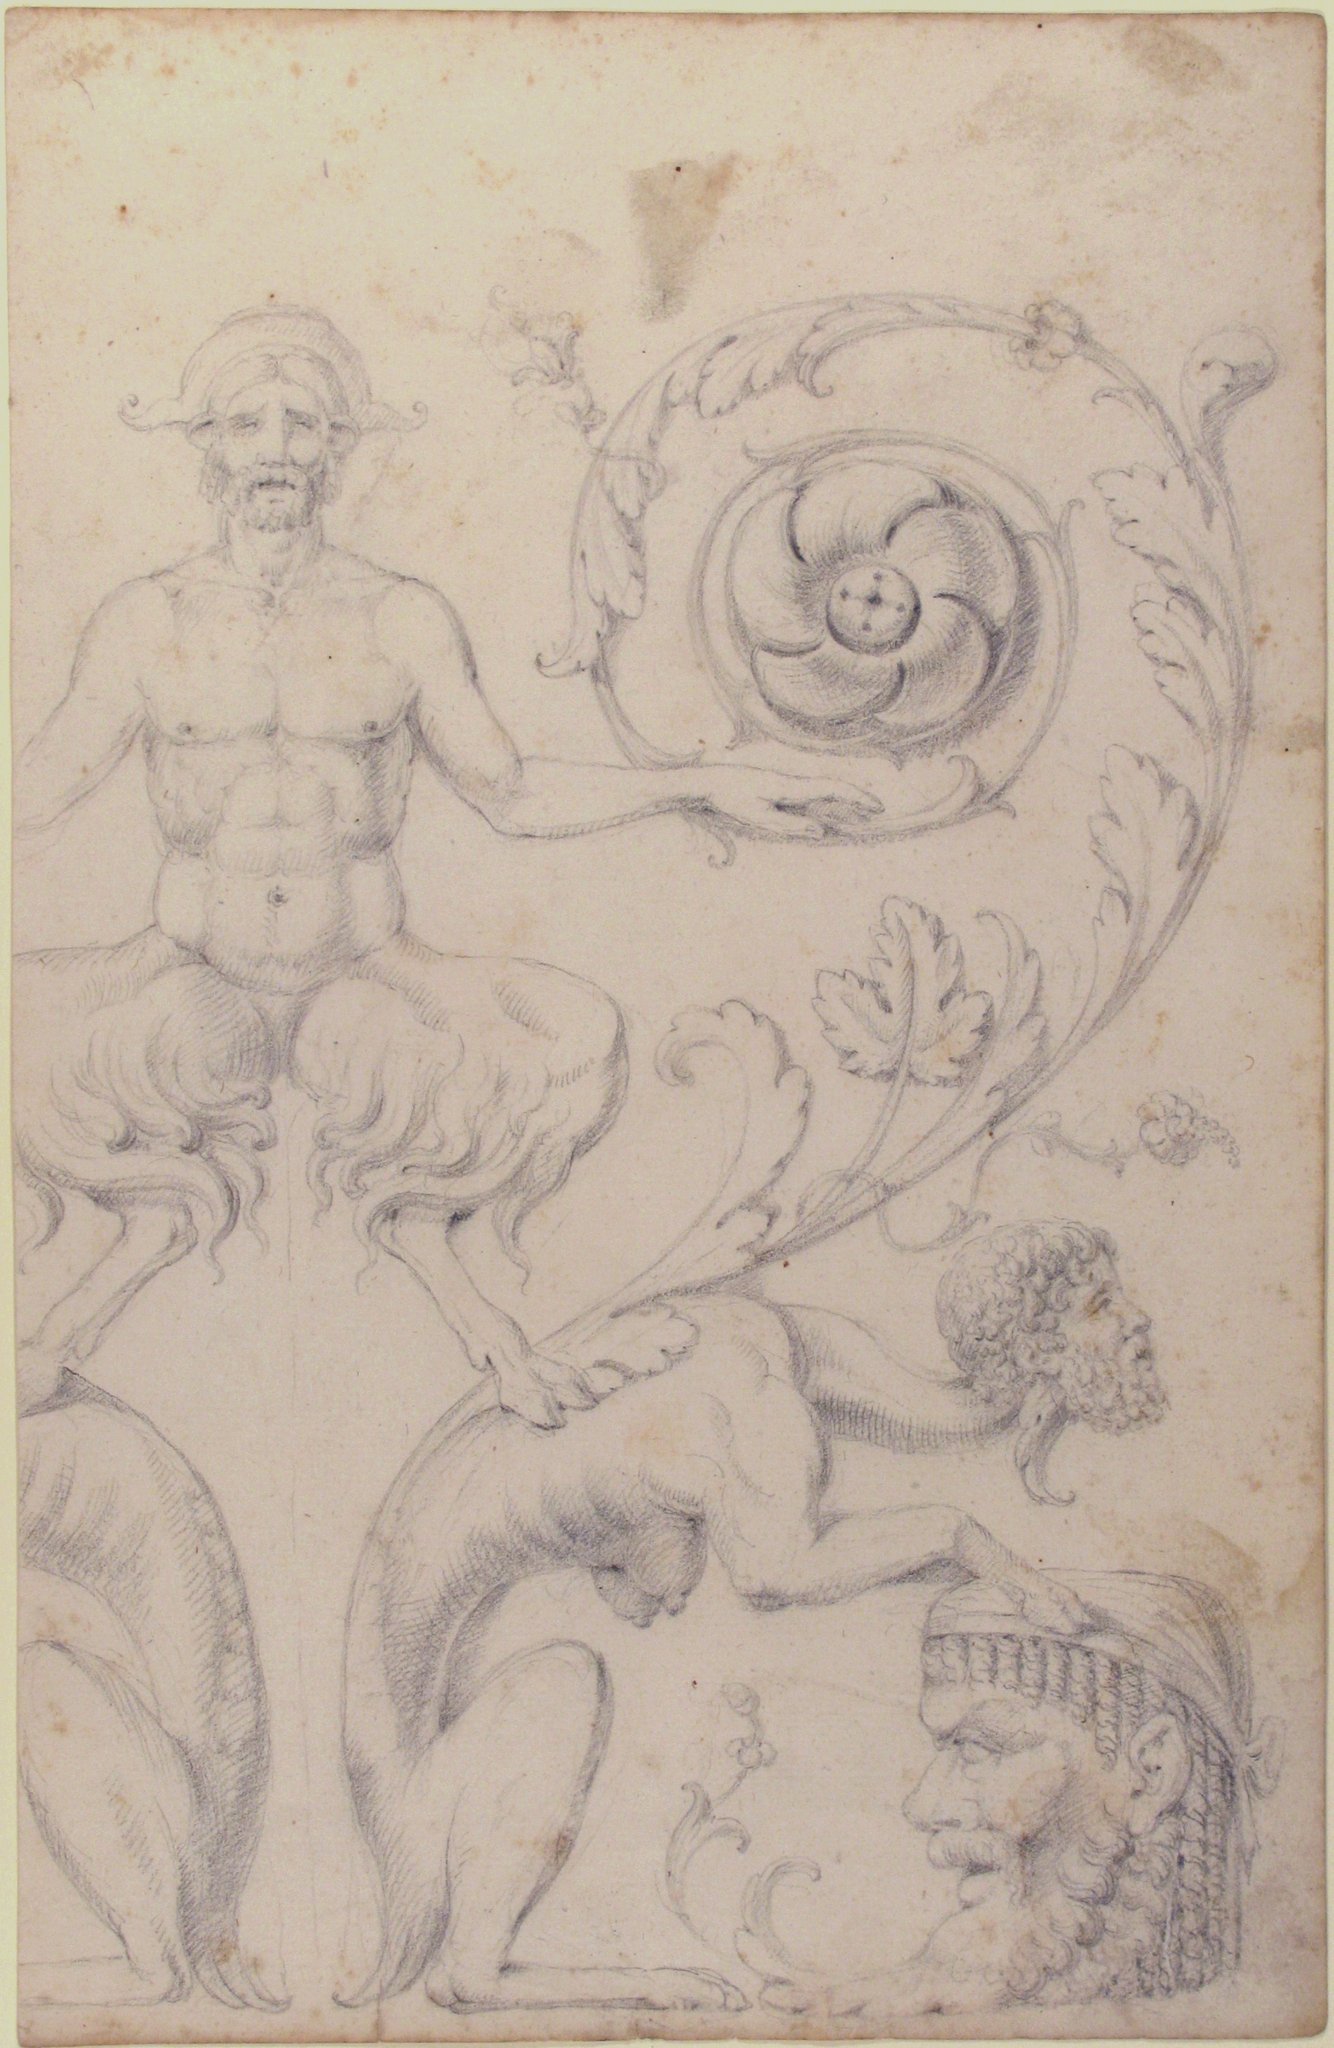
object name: drawing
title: Drawing of a Grotesque after a 16th-century Decorative Relief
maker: filippo cretoni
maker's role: artist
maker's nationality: italian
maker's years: 18-19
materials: chalk, graphite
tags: grotesques,ornament,mythical creatures